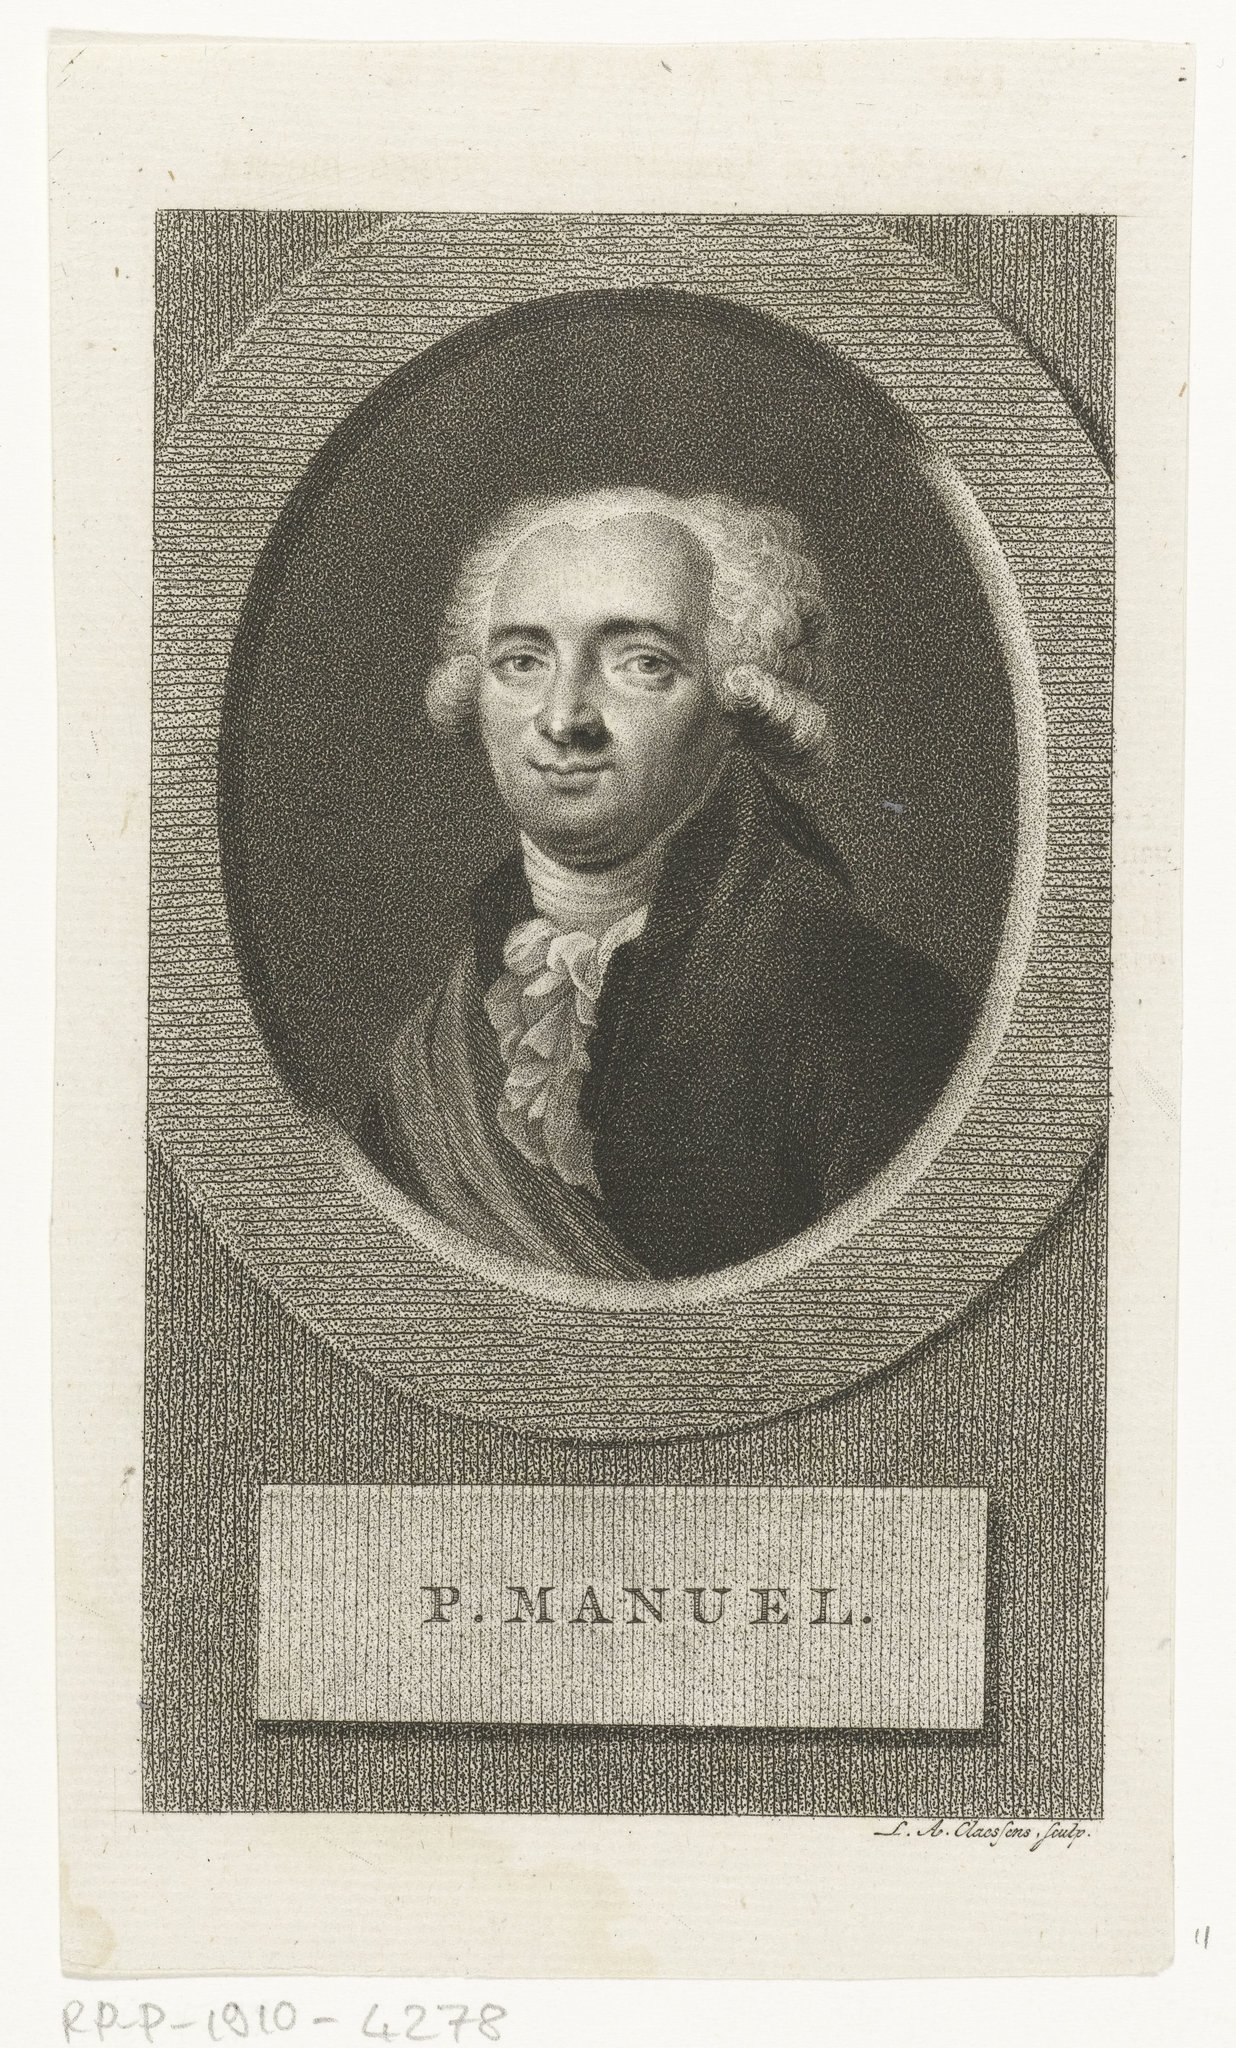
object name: print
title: Portret van Pierre Louis Manuel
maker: lambertus antonius claessens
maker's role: draughtsman, print maker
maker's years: 1763-1834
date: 1792-1808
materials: paper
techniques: engraving, etching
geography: amsterdam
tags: schrijver, revolutionair, pierre louis manuel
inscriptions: collector's mark: Lugt 2228